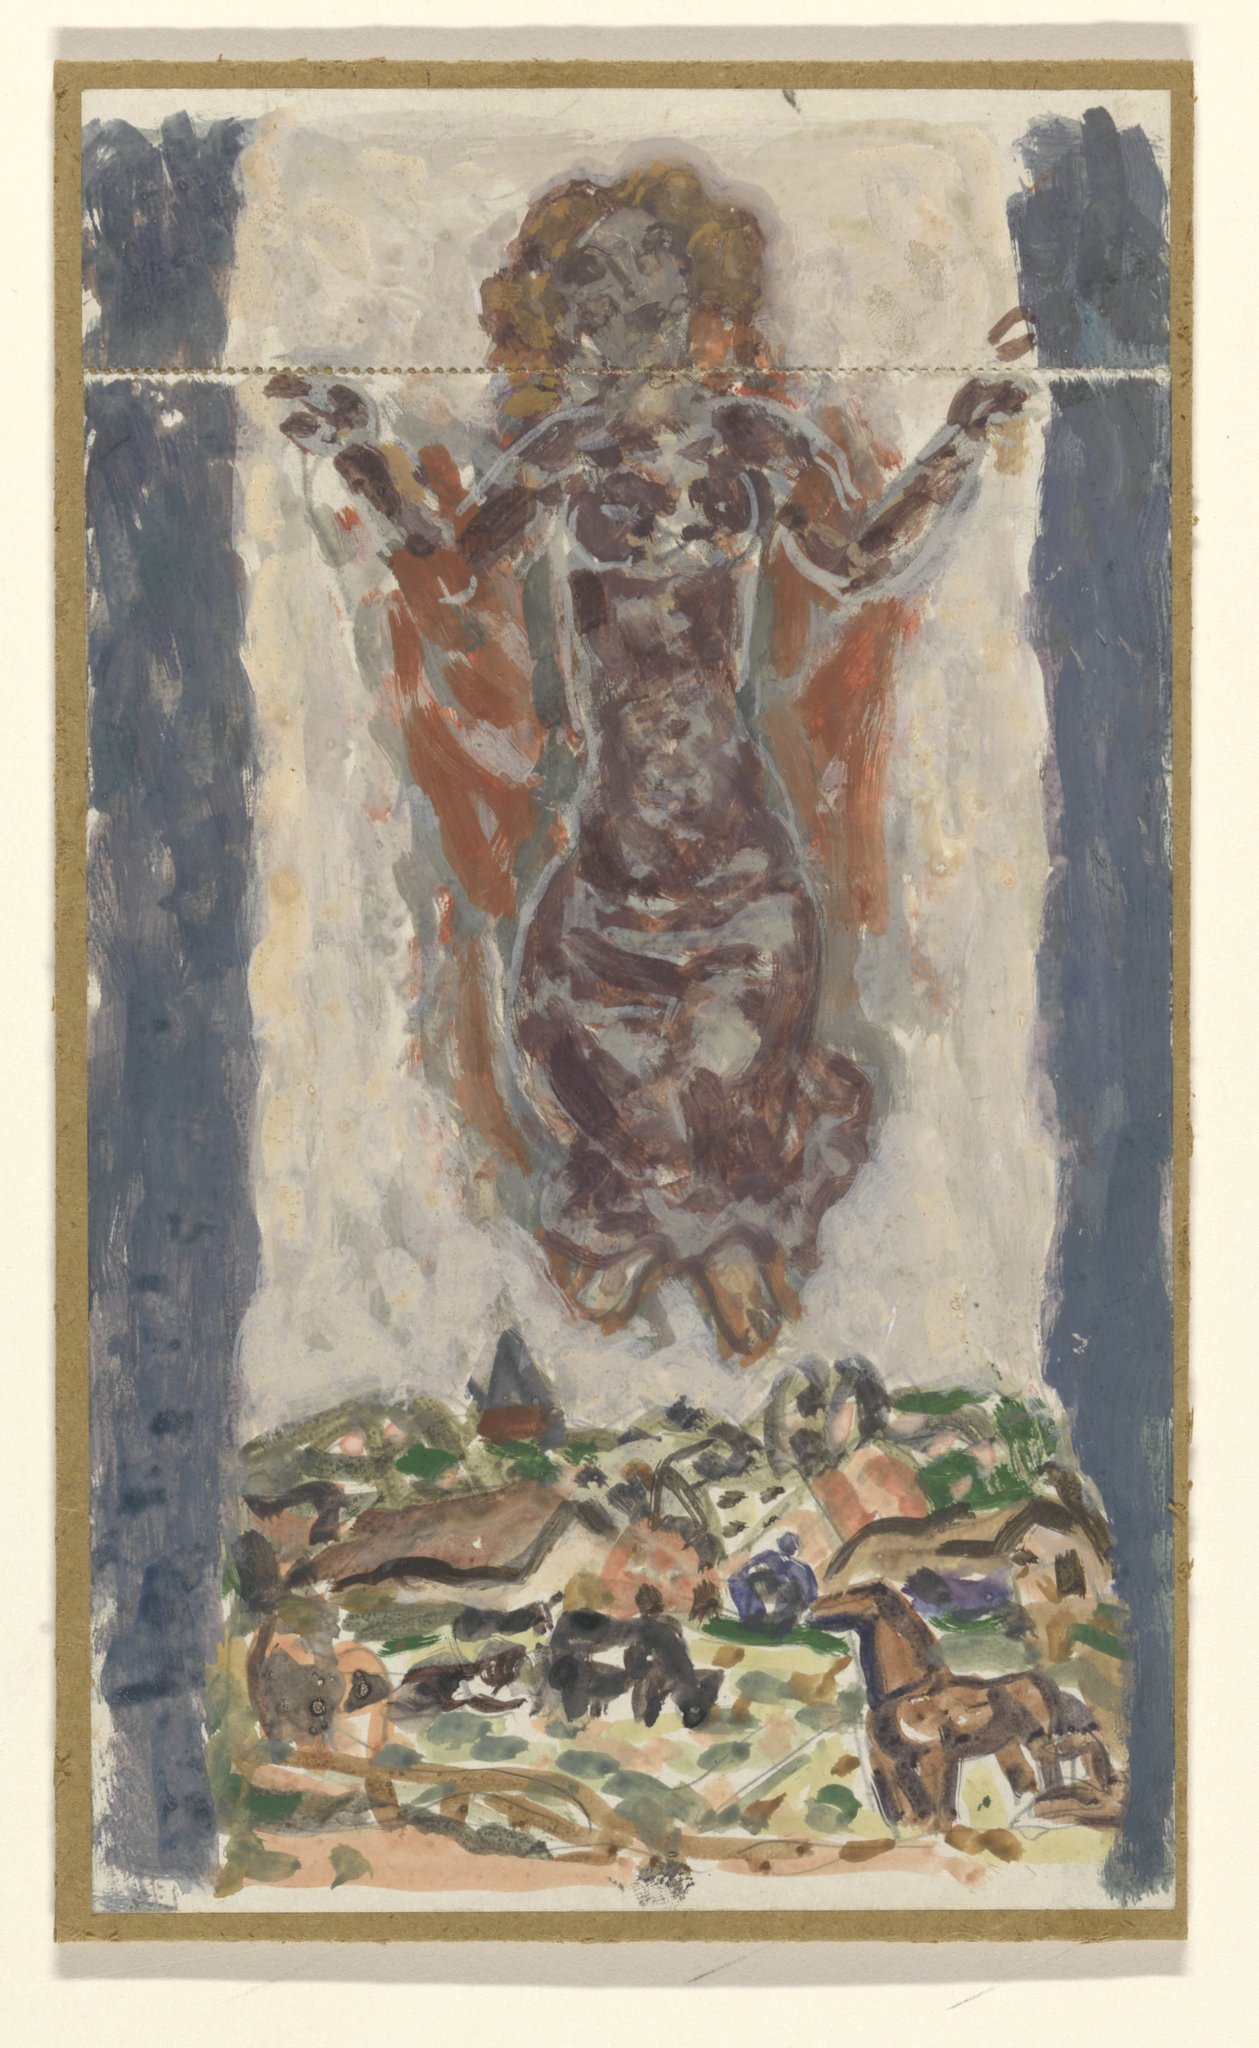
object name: drawing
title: Vrouw met gespreide armen boven een landschap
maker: leo gestel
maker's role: draughtsman, print maker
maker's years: 1881-1941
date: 1891-1941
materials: cardboard, gouache, paper, pencil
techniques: brush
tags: landscapes, female sex; woman